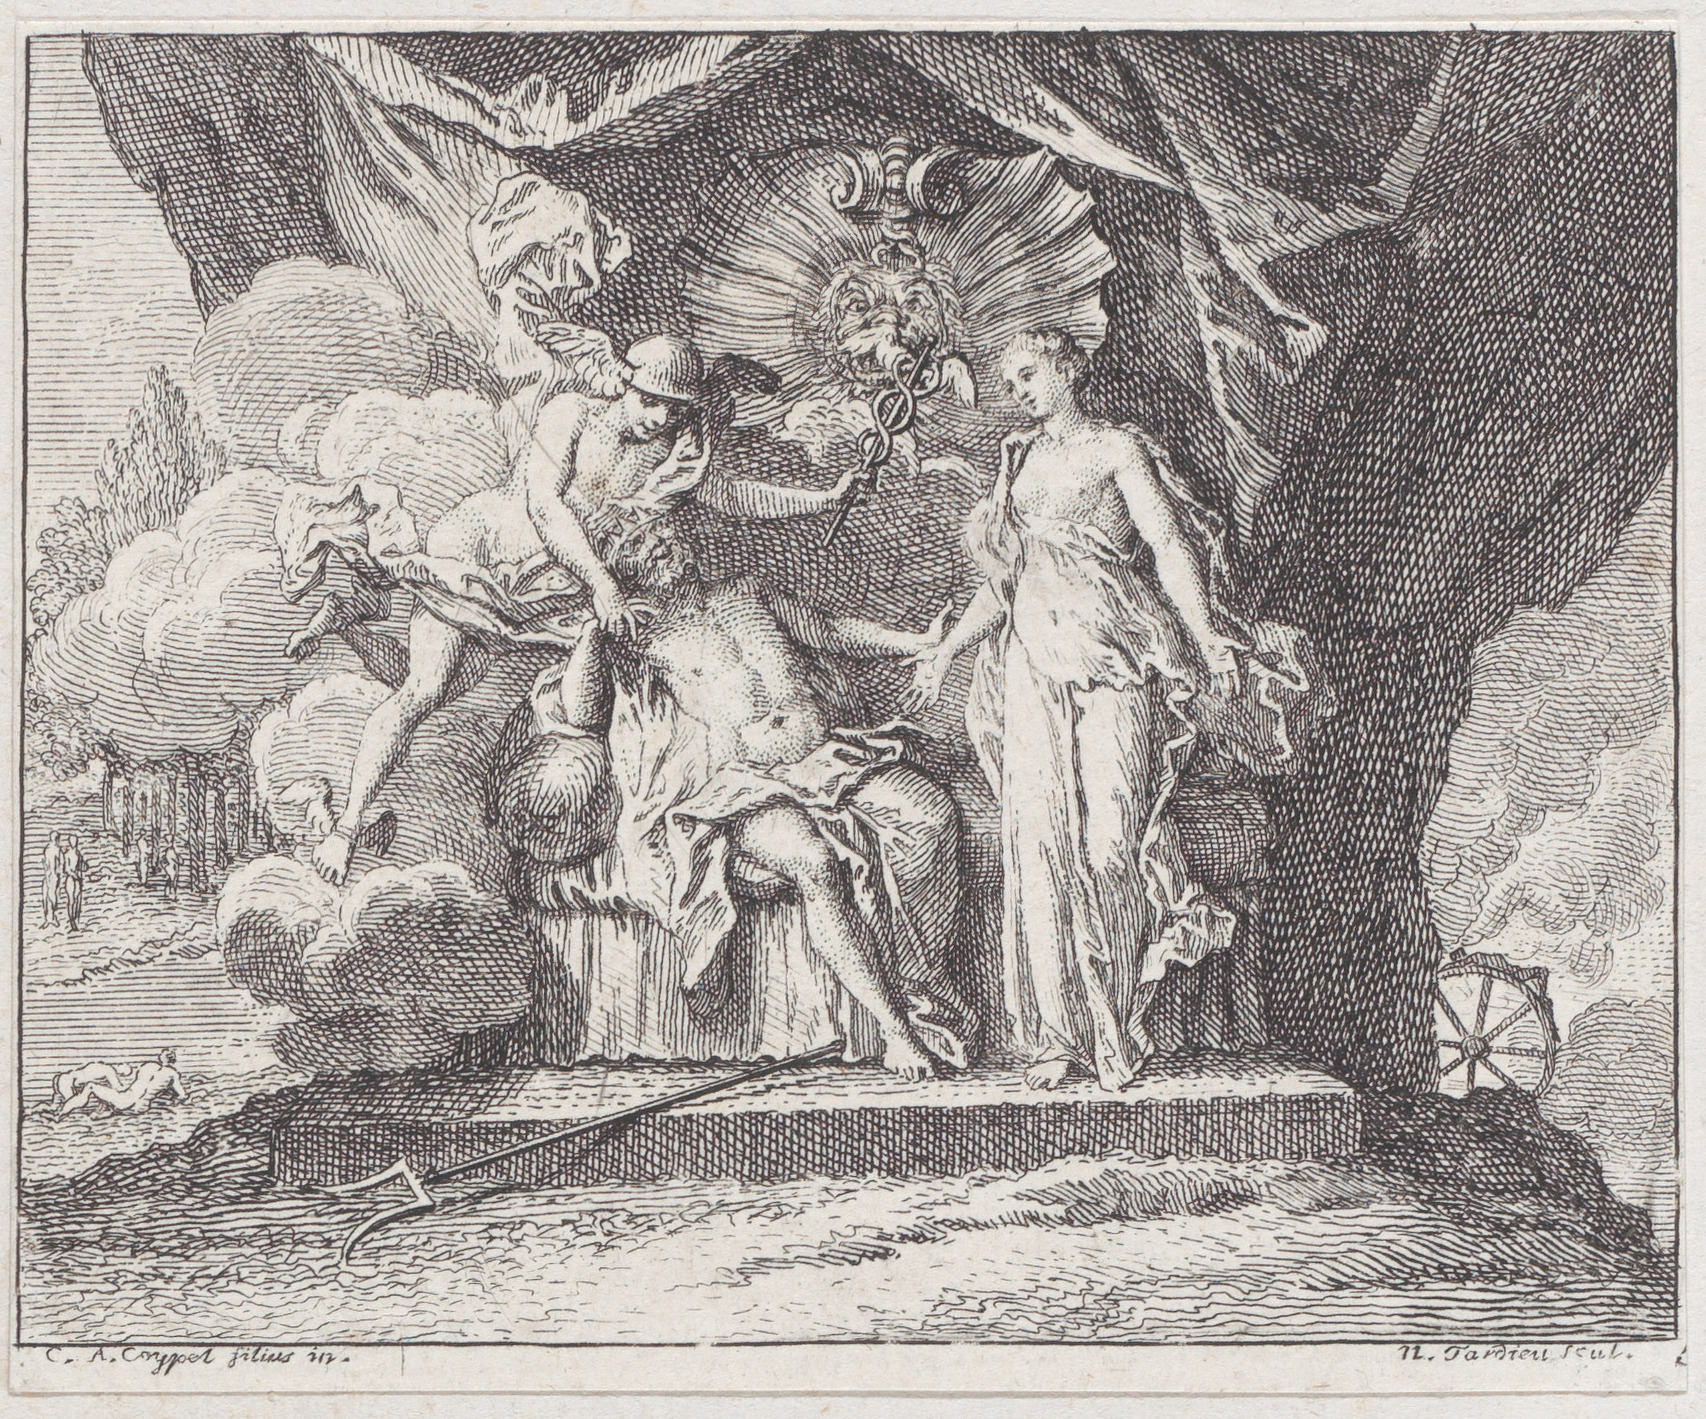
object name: print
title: Book 3, Fable 12: Pluto and Proserpina, from "Fables Nouvelles"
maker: nicolas henry tardieu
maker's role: artist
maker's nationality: french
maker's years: 1674-1749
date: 1719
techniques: engraving, etching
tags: men,women,pluto